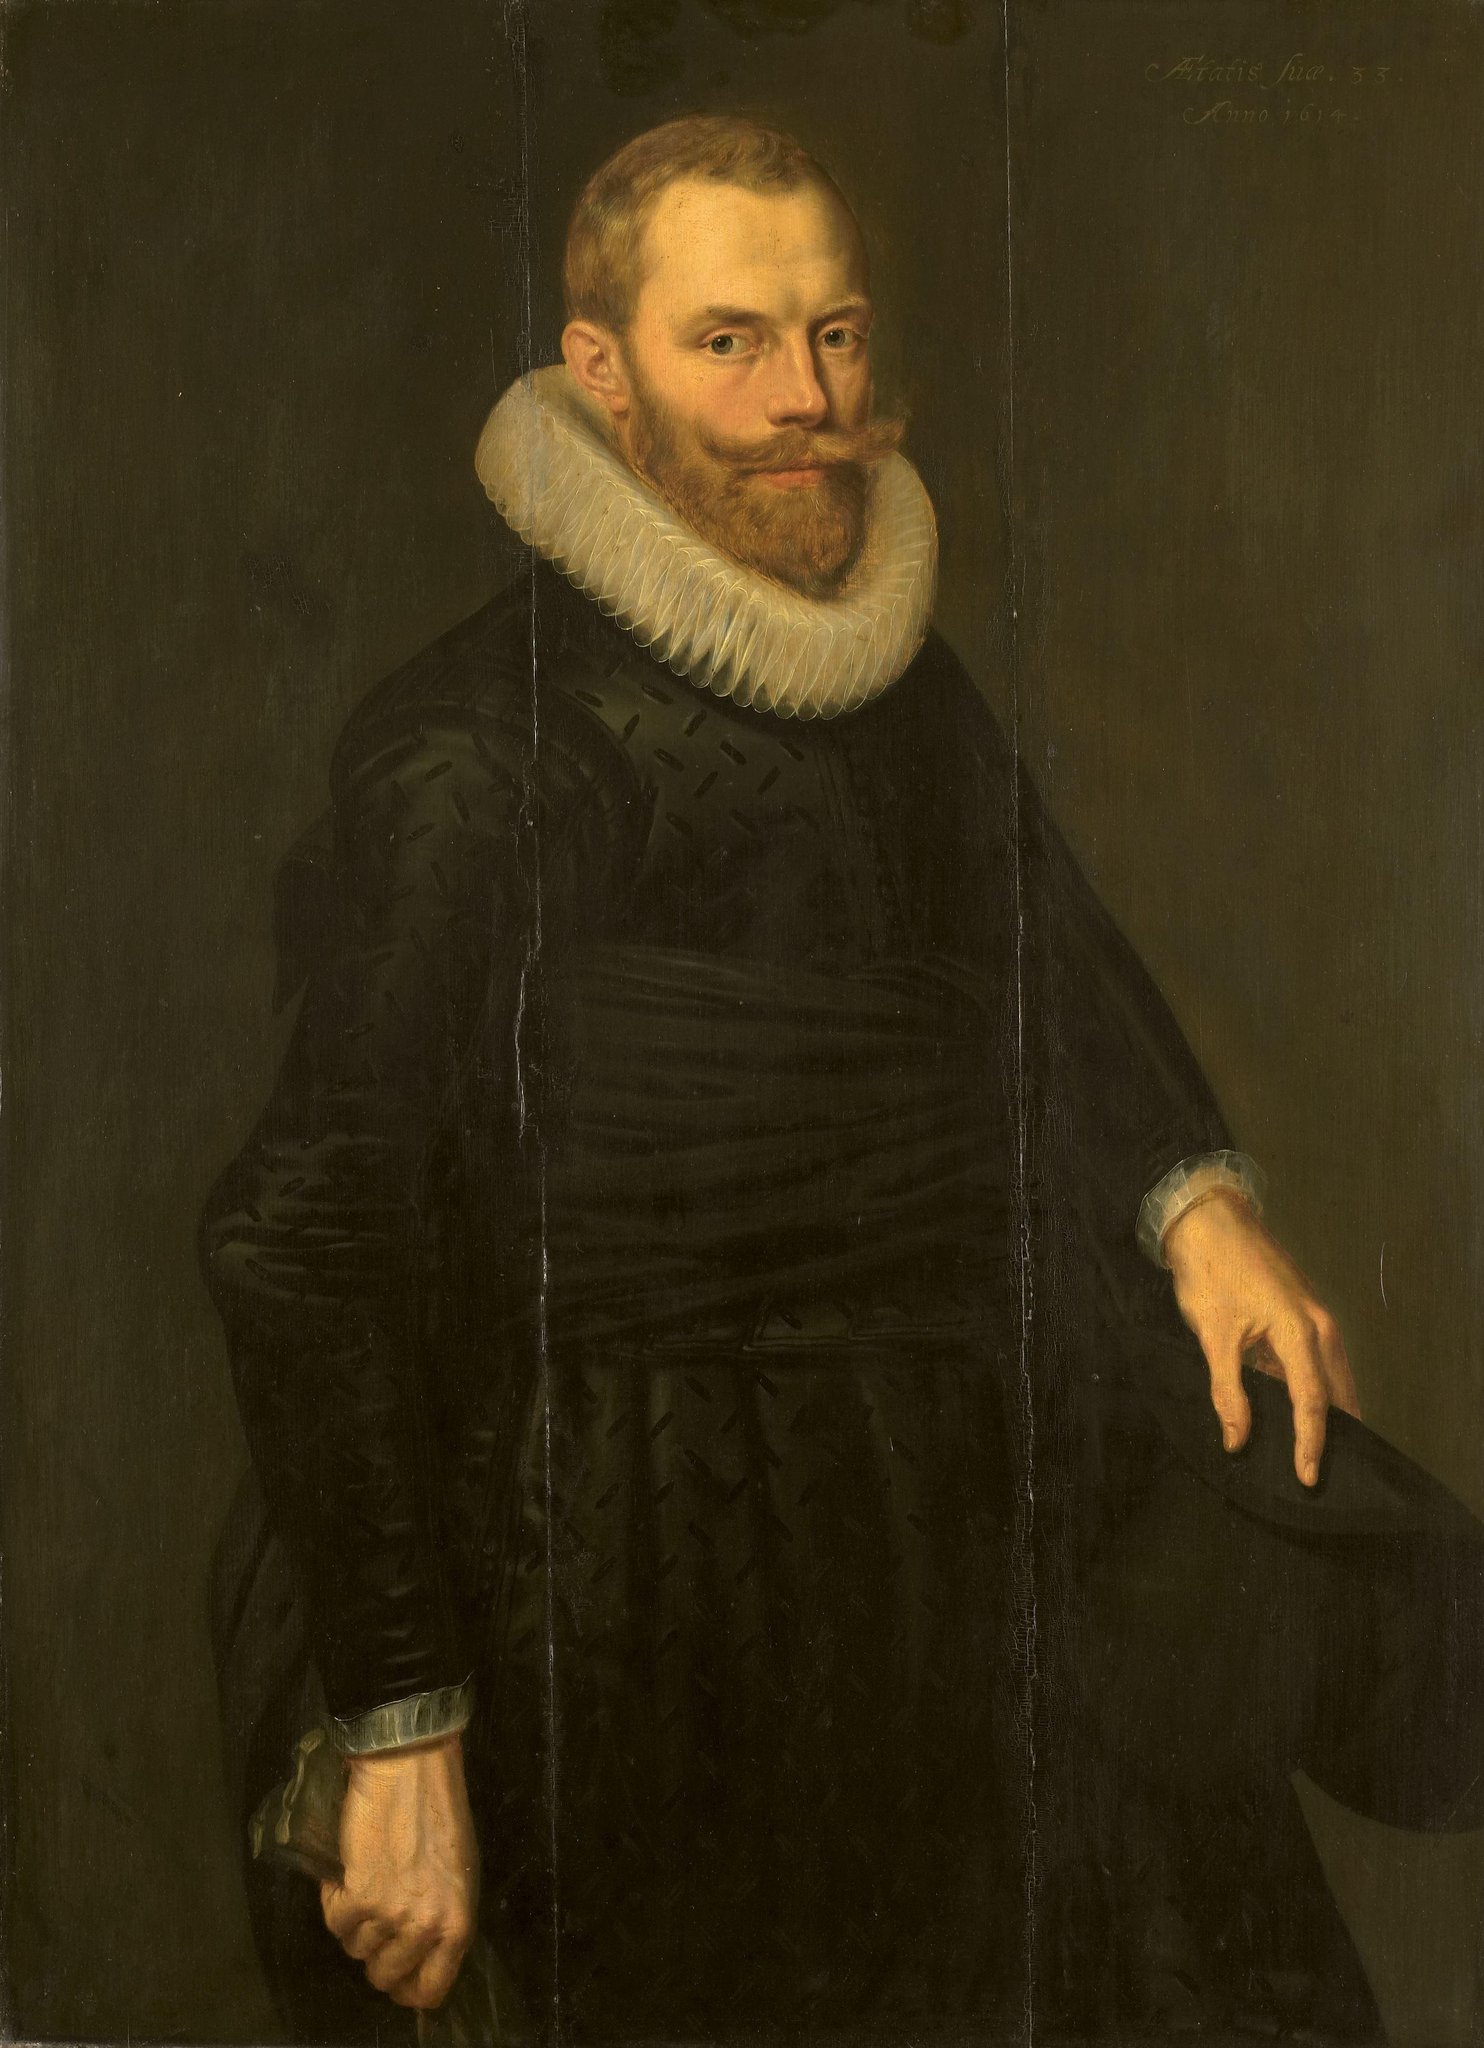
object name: painting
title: Portrait of Dirck Hasselaer (1581-1645)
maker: cornelis van der voort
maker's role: draughtsman, painter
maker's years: 1576-1624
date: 1614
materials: oil, panel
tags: historical persons, amsterdam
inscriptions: inscription and date, upper right: ‘Ætatis Suae.33. / Anno 1614.’, label, on the reverse of the painting: ‘Bregje van Schoterbosch / vrouwe van Dirk Hasselaar: / Vader en Moeder van Aagje Hasselaar / vrouwe van Henrick Hooft. / Vader en Moeder van Bregje van de Poll, / vrouwe van Harman van de Poll’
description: Portret van Dirck Hasselaer (1581-1645). Koopman te Amsterdam, bewindhebber der Verenigde Oostindische Compagnie. Kniestuk, staande met handschoenen in de rechterhand en zijn hoed in de linkerhand. Pendant van SK-A-1243.